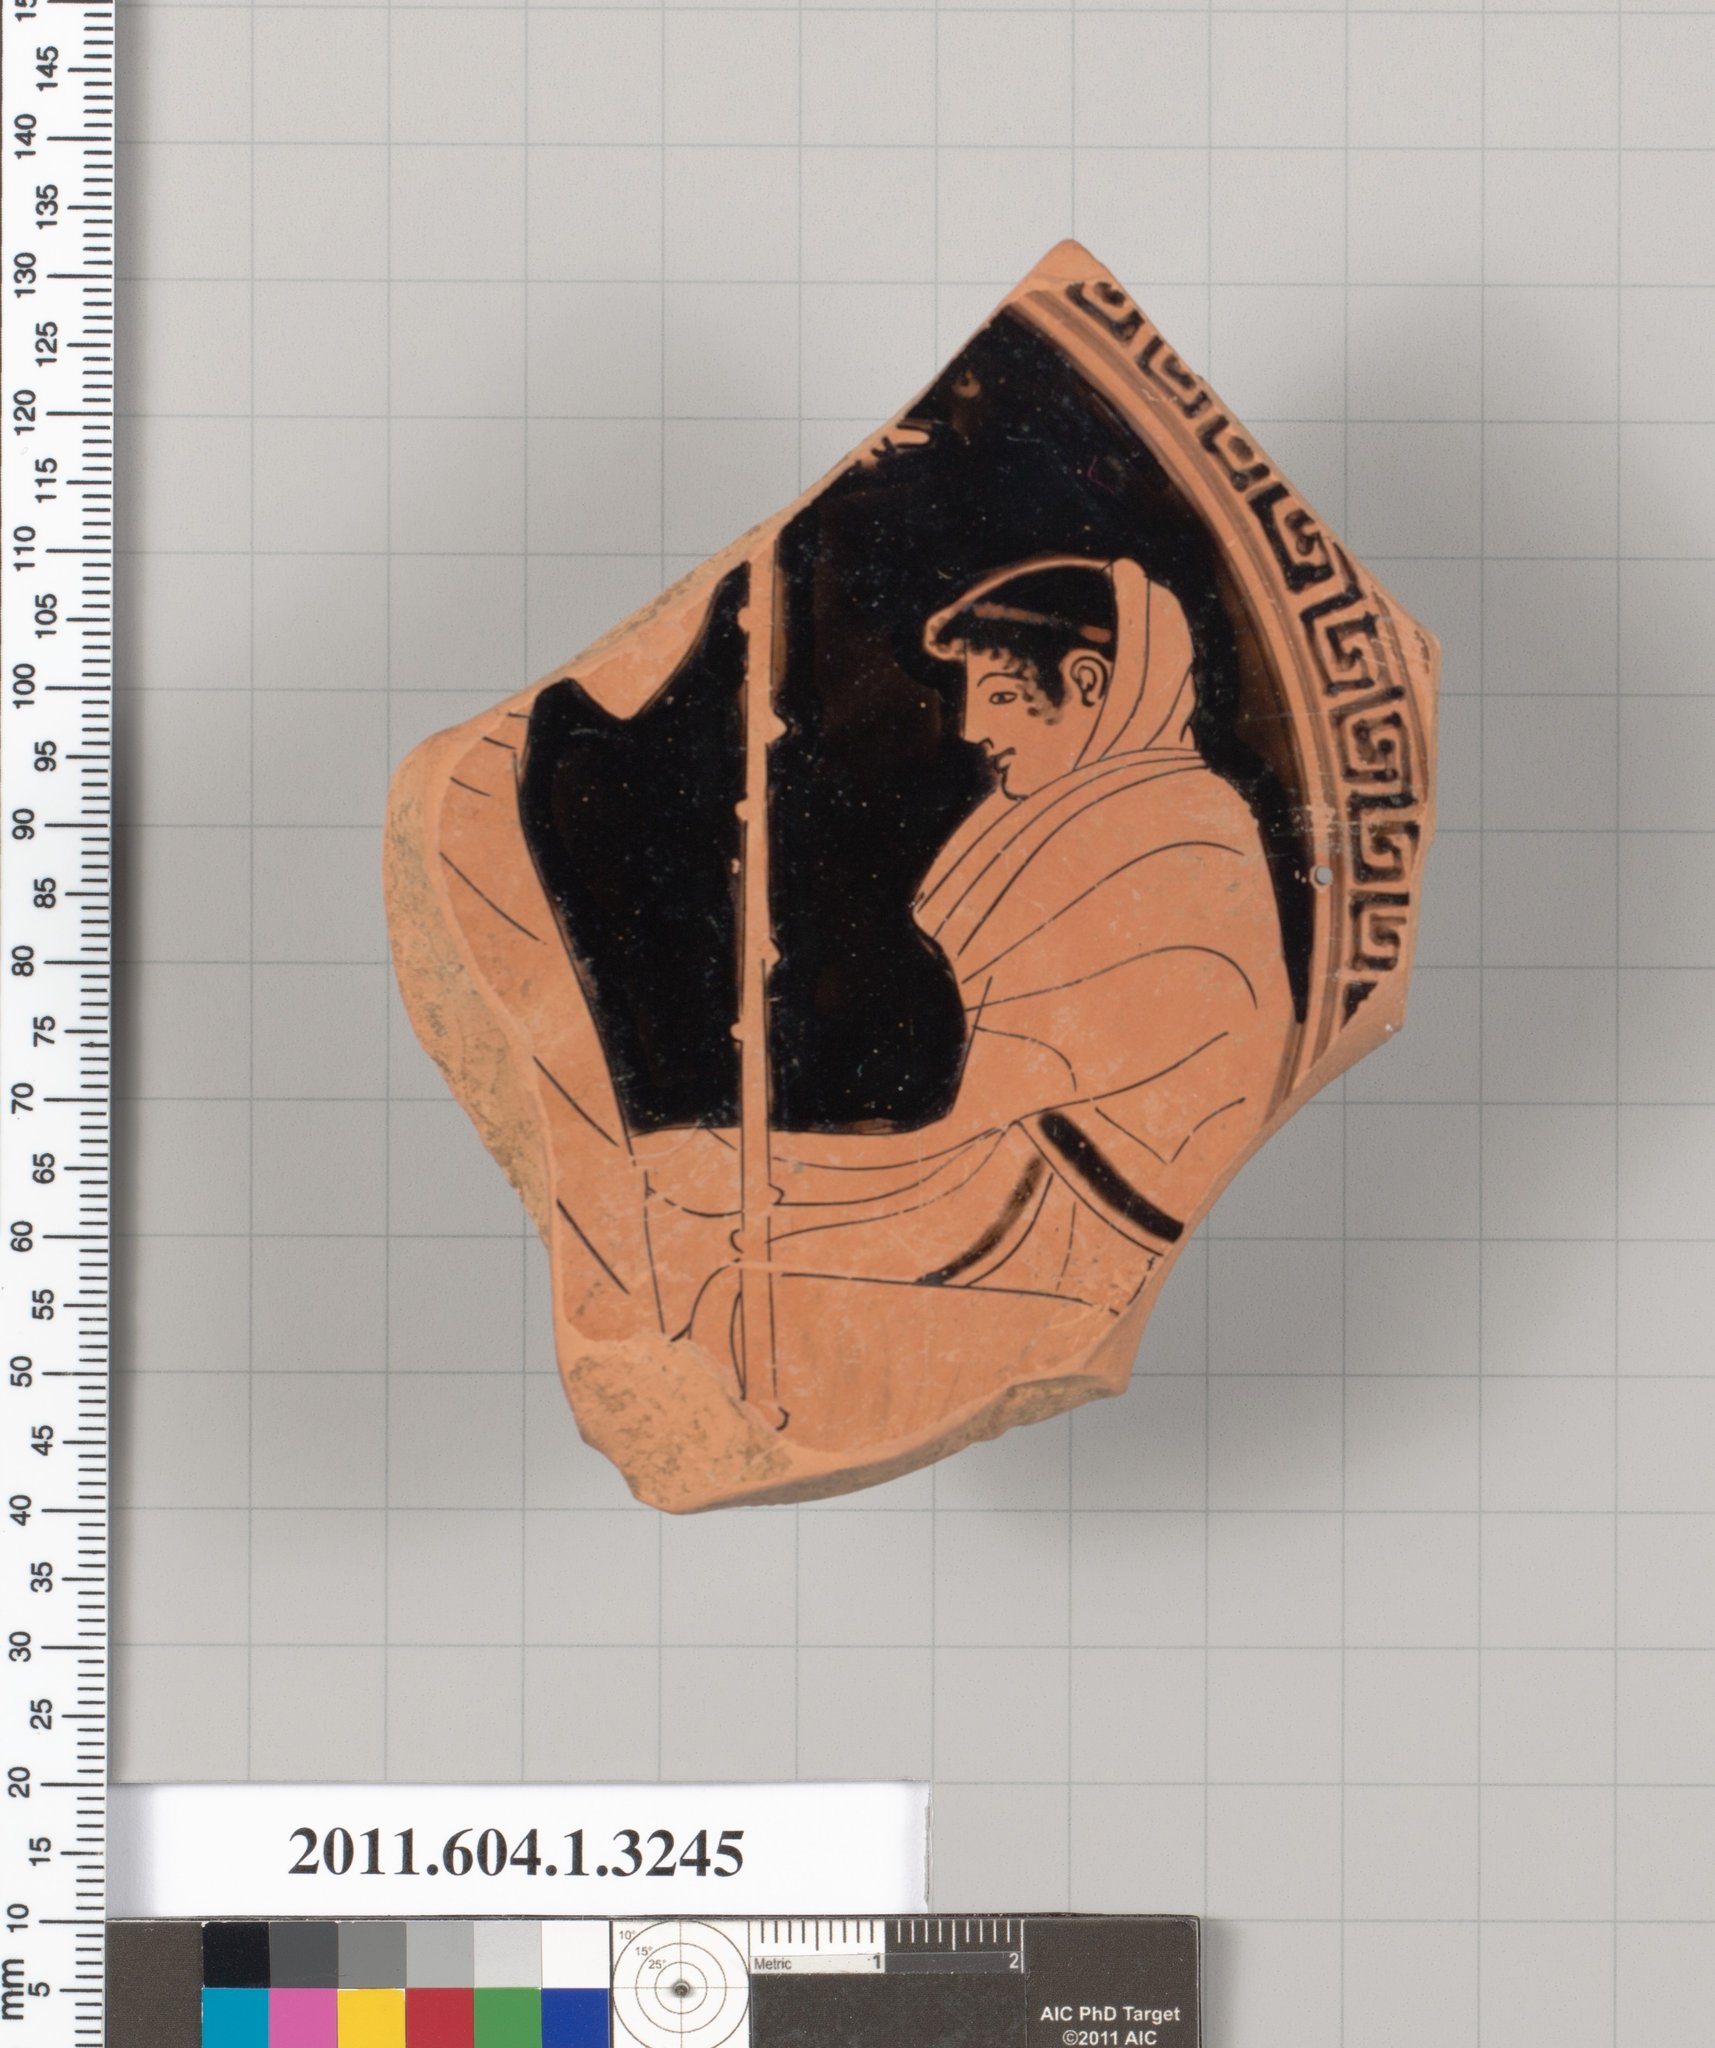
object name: kylix fragment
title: Terracotta fragment of a kylix (drinking cup)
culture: greek, attic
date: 490-470 BCE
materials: terracotta